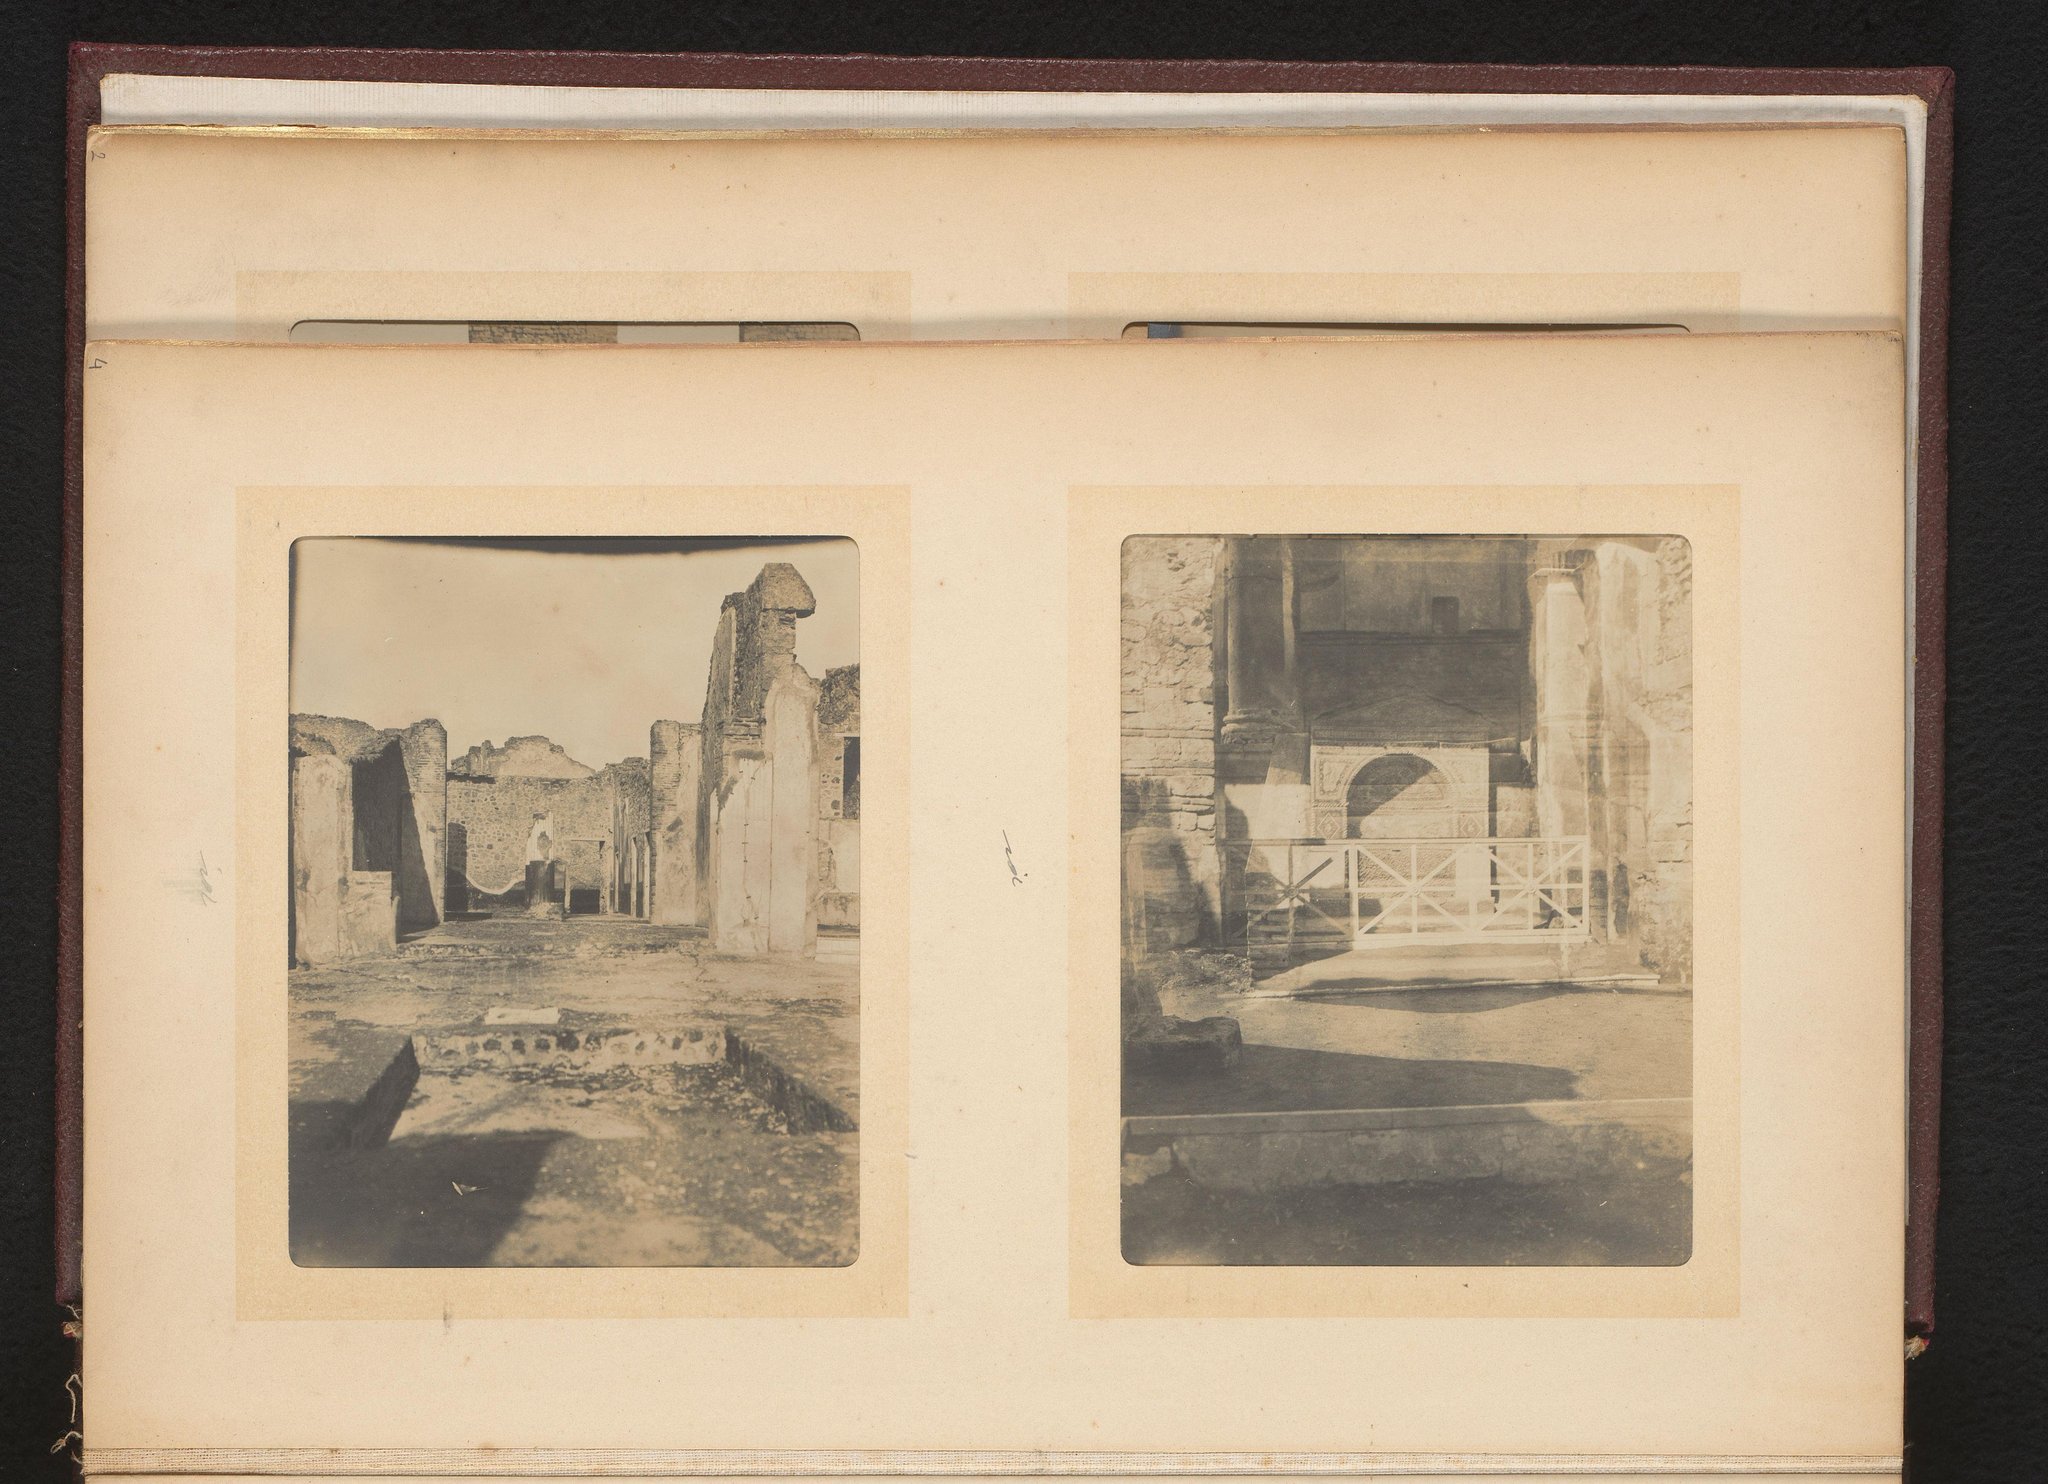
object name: photograph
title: Twee gezichten in Pompeï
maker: Anonymous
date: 1895-1905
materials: cardboard, photographic support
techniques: gelatin silver print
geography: pompeii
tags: tourism, landscape with ruins, pompeii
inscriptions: inscription: ‘id. / id.’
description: Albumblad met twee foto's in Pompeï. Onderdeel van een fotoalbum van een reis door Italië, ca. 1900.